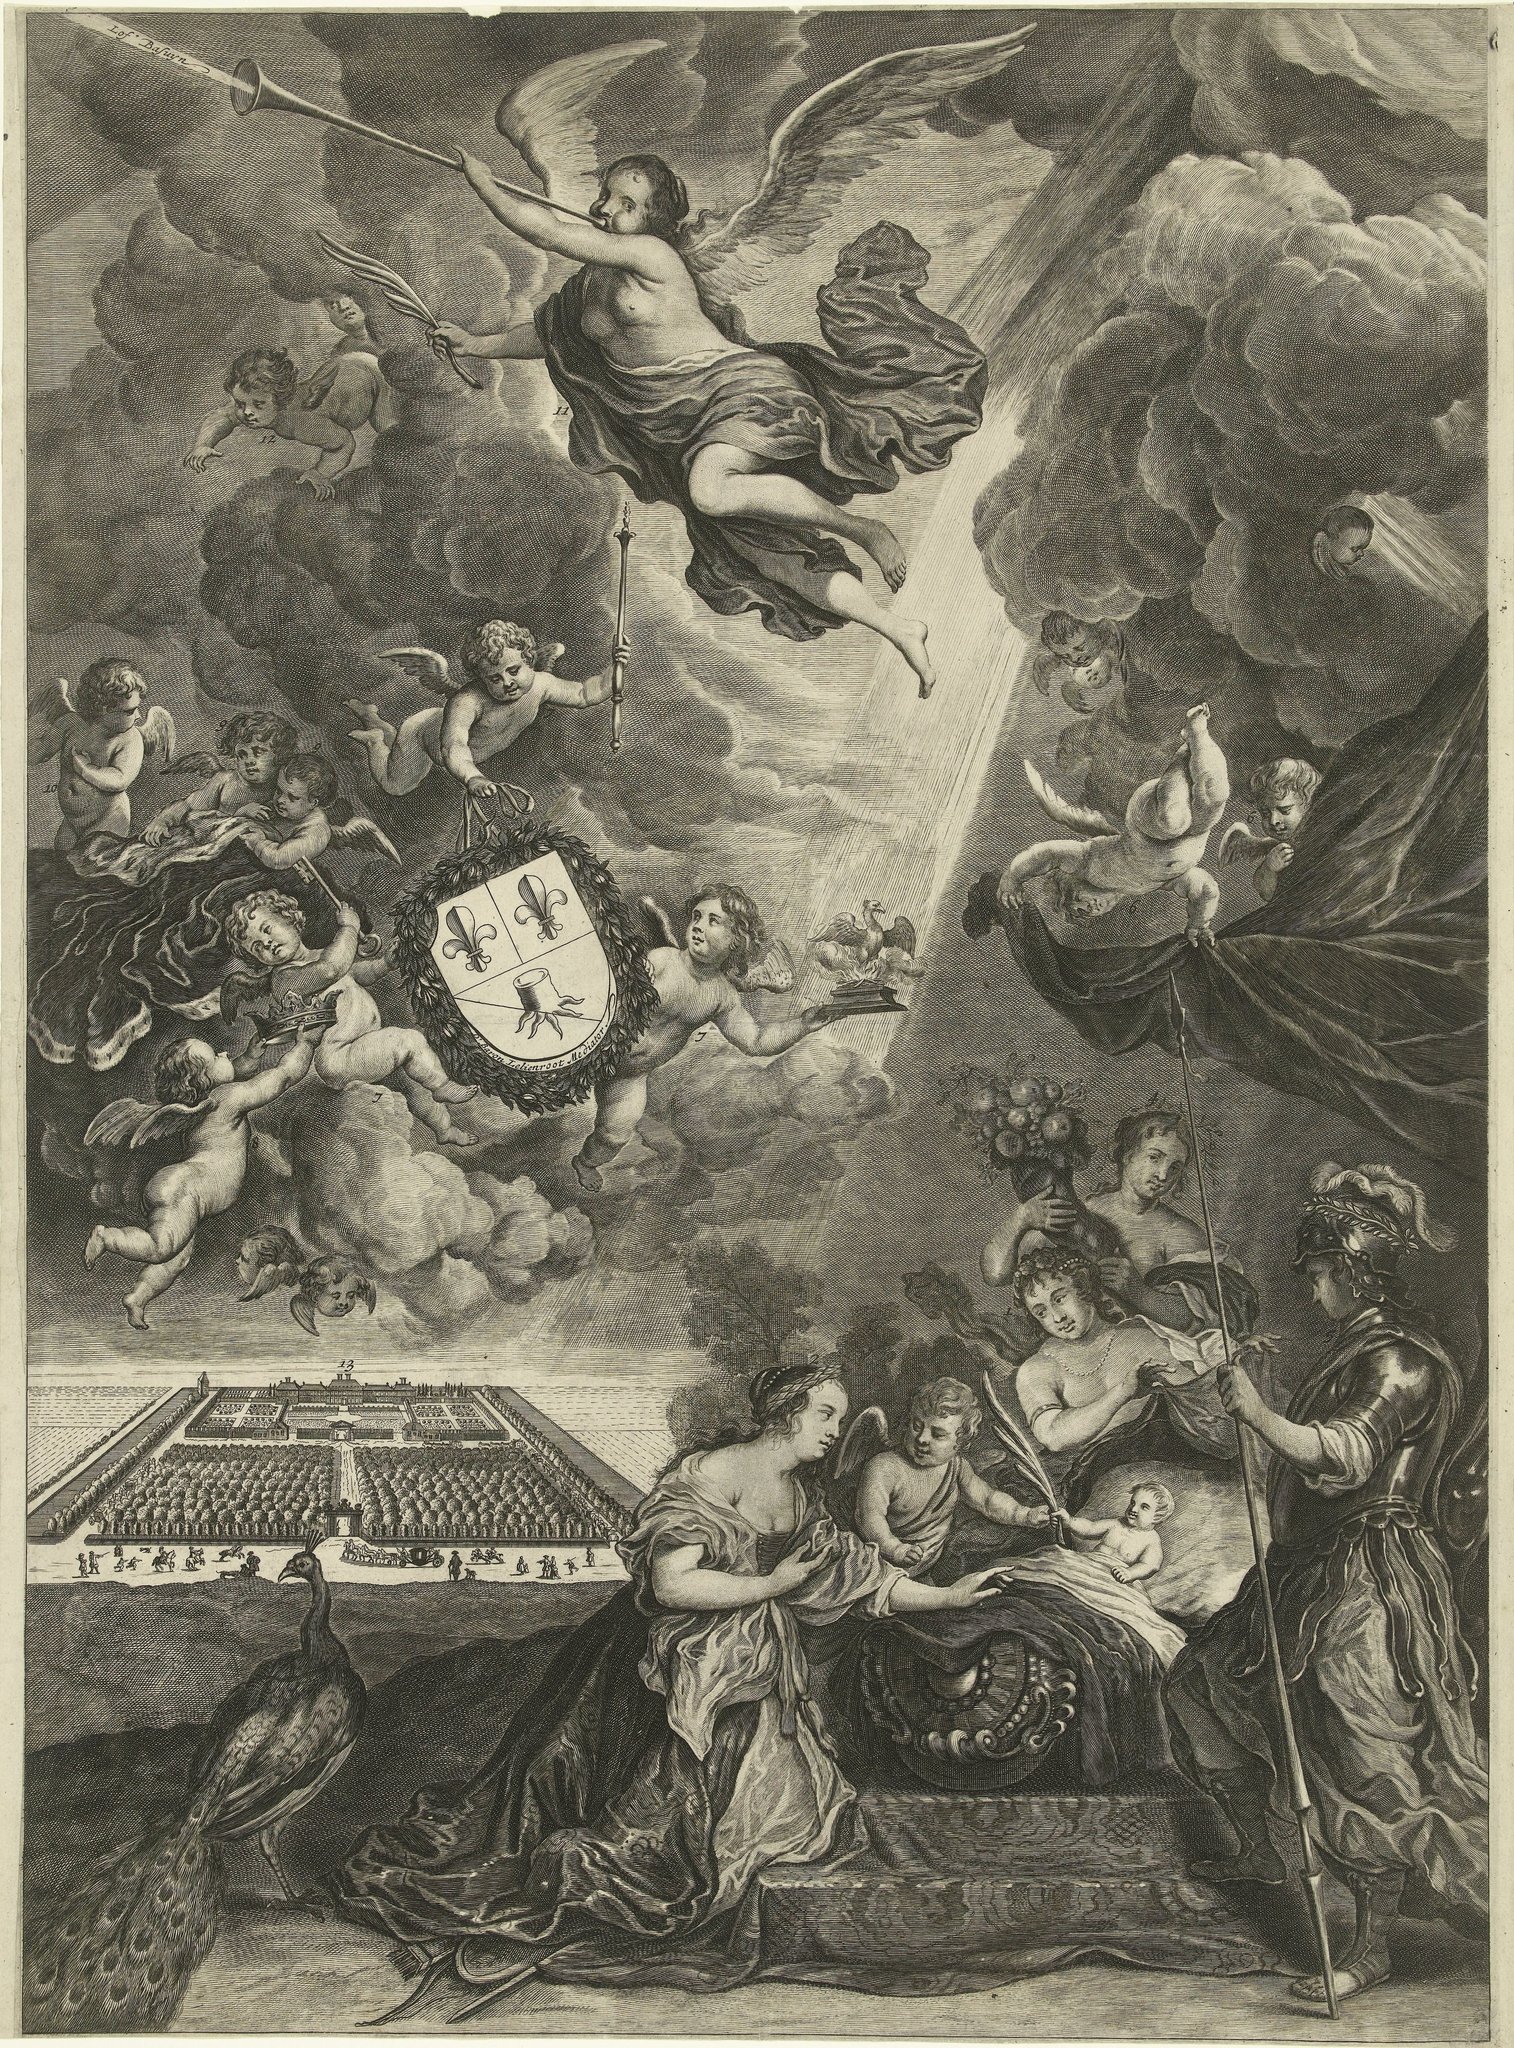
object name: print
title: Allegorie op de Vrede van Rijswijk, 1697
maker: cornelis van dalen (i)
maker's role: print maker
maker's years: 1602-1665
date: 1649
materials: paper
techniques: engraving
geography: northern netherlands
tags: fame; 'fama', 'fama buona', 'fama chiara' (ripa)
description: Allegorie op de Vrede van Rijswijk, 20 september 1697. Om de wieg van het vredeskindje met palmtak in de hand staan en knielen Minerva, Juno en Cupido en Overvloed. Links de pauwen van Juno. In het verschiet het Huis te Nieuburch (Rijswijk) waar de vredesonderhandelingen plaatsvonden. In de lucht dragen engelen het wapen van de Zweedse mediator Baron Lelienroot en verkondigt de Faam met palmtak en bazuin het nieuws van de vrede. Details in de voorstelling genummerd 1-13 maar de verklaring ontbreekt.